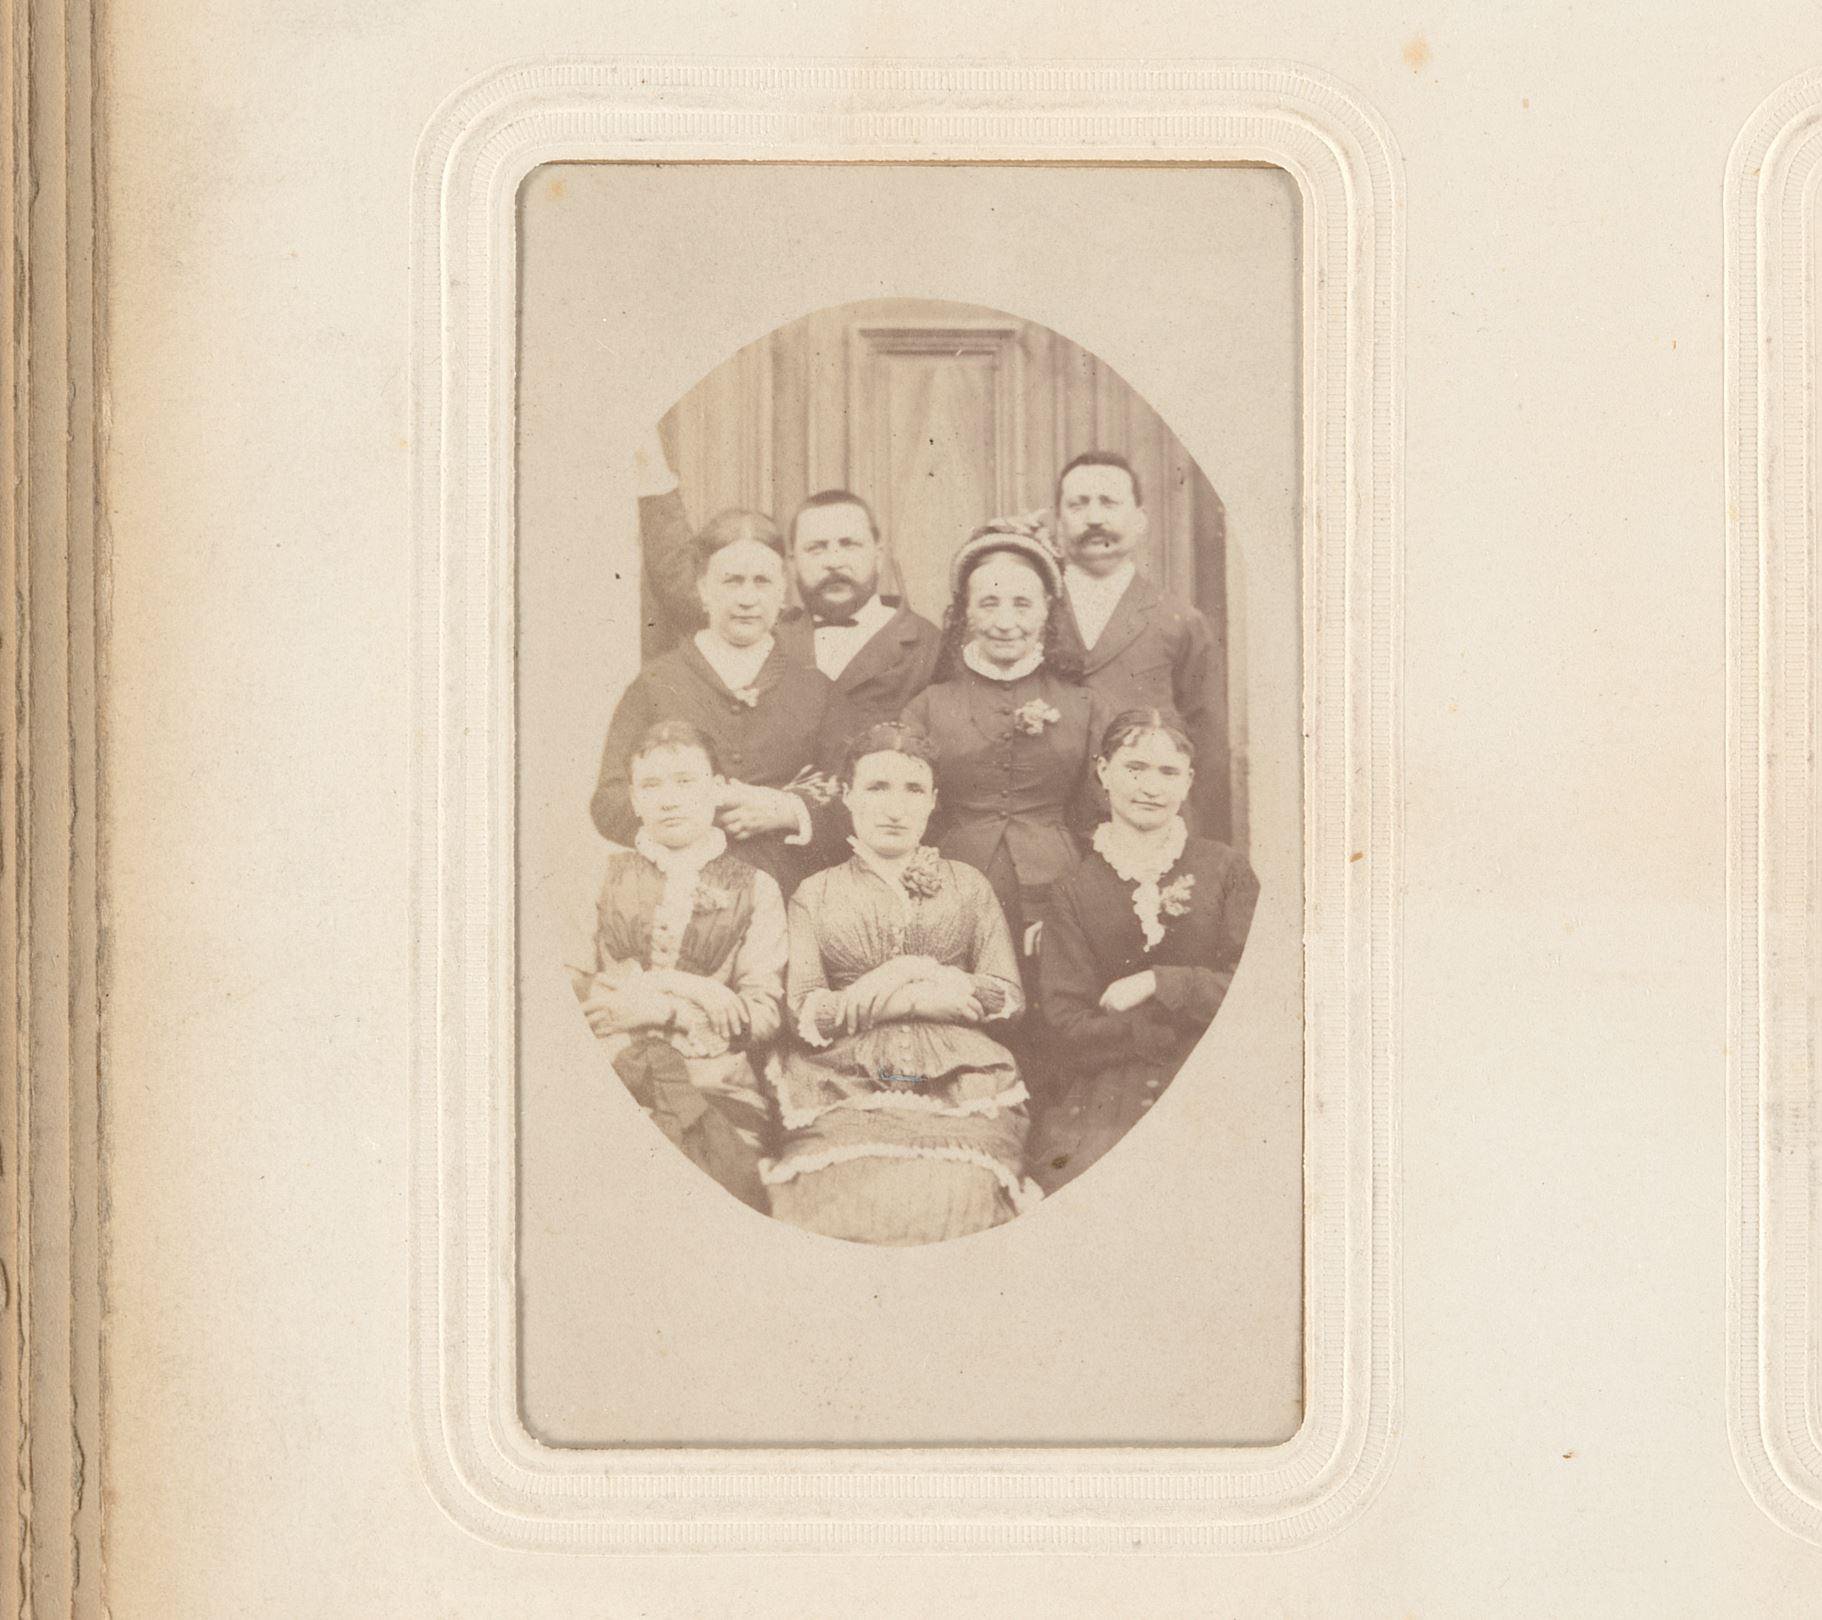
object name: album leaf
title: Groepsportret van twee mannen en vijf vrouwen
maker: Anonymous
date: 1865-1900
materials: cardboard, paper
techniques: albumen print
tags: adult man (+ two persons), adult woman (+ five persons), historical persons